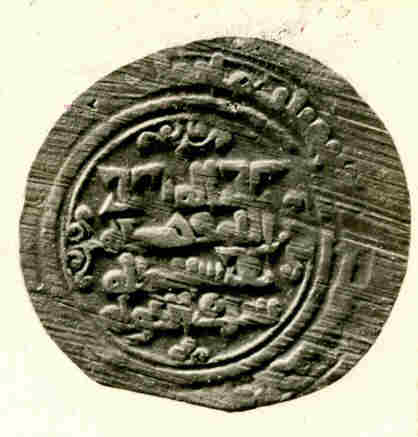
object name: coin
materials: copper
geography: iran